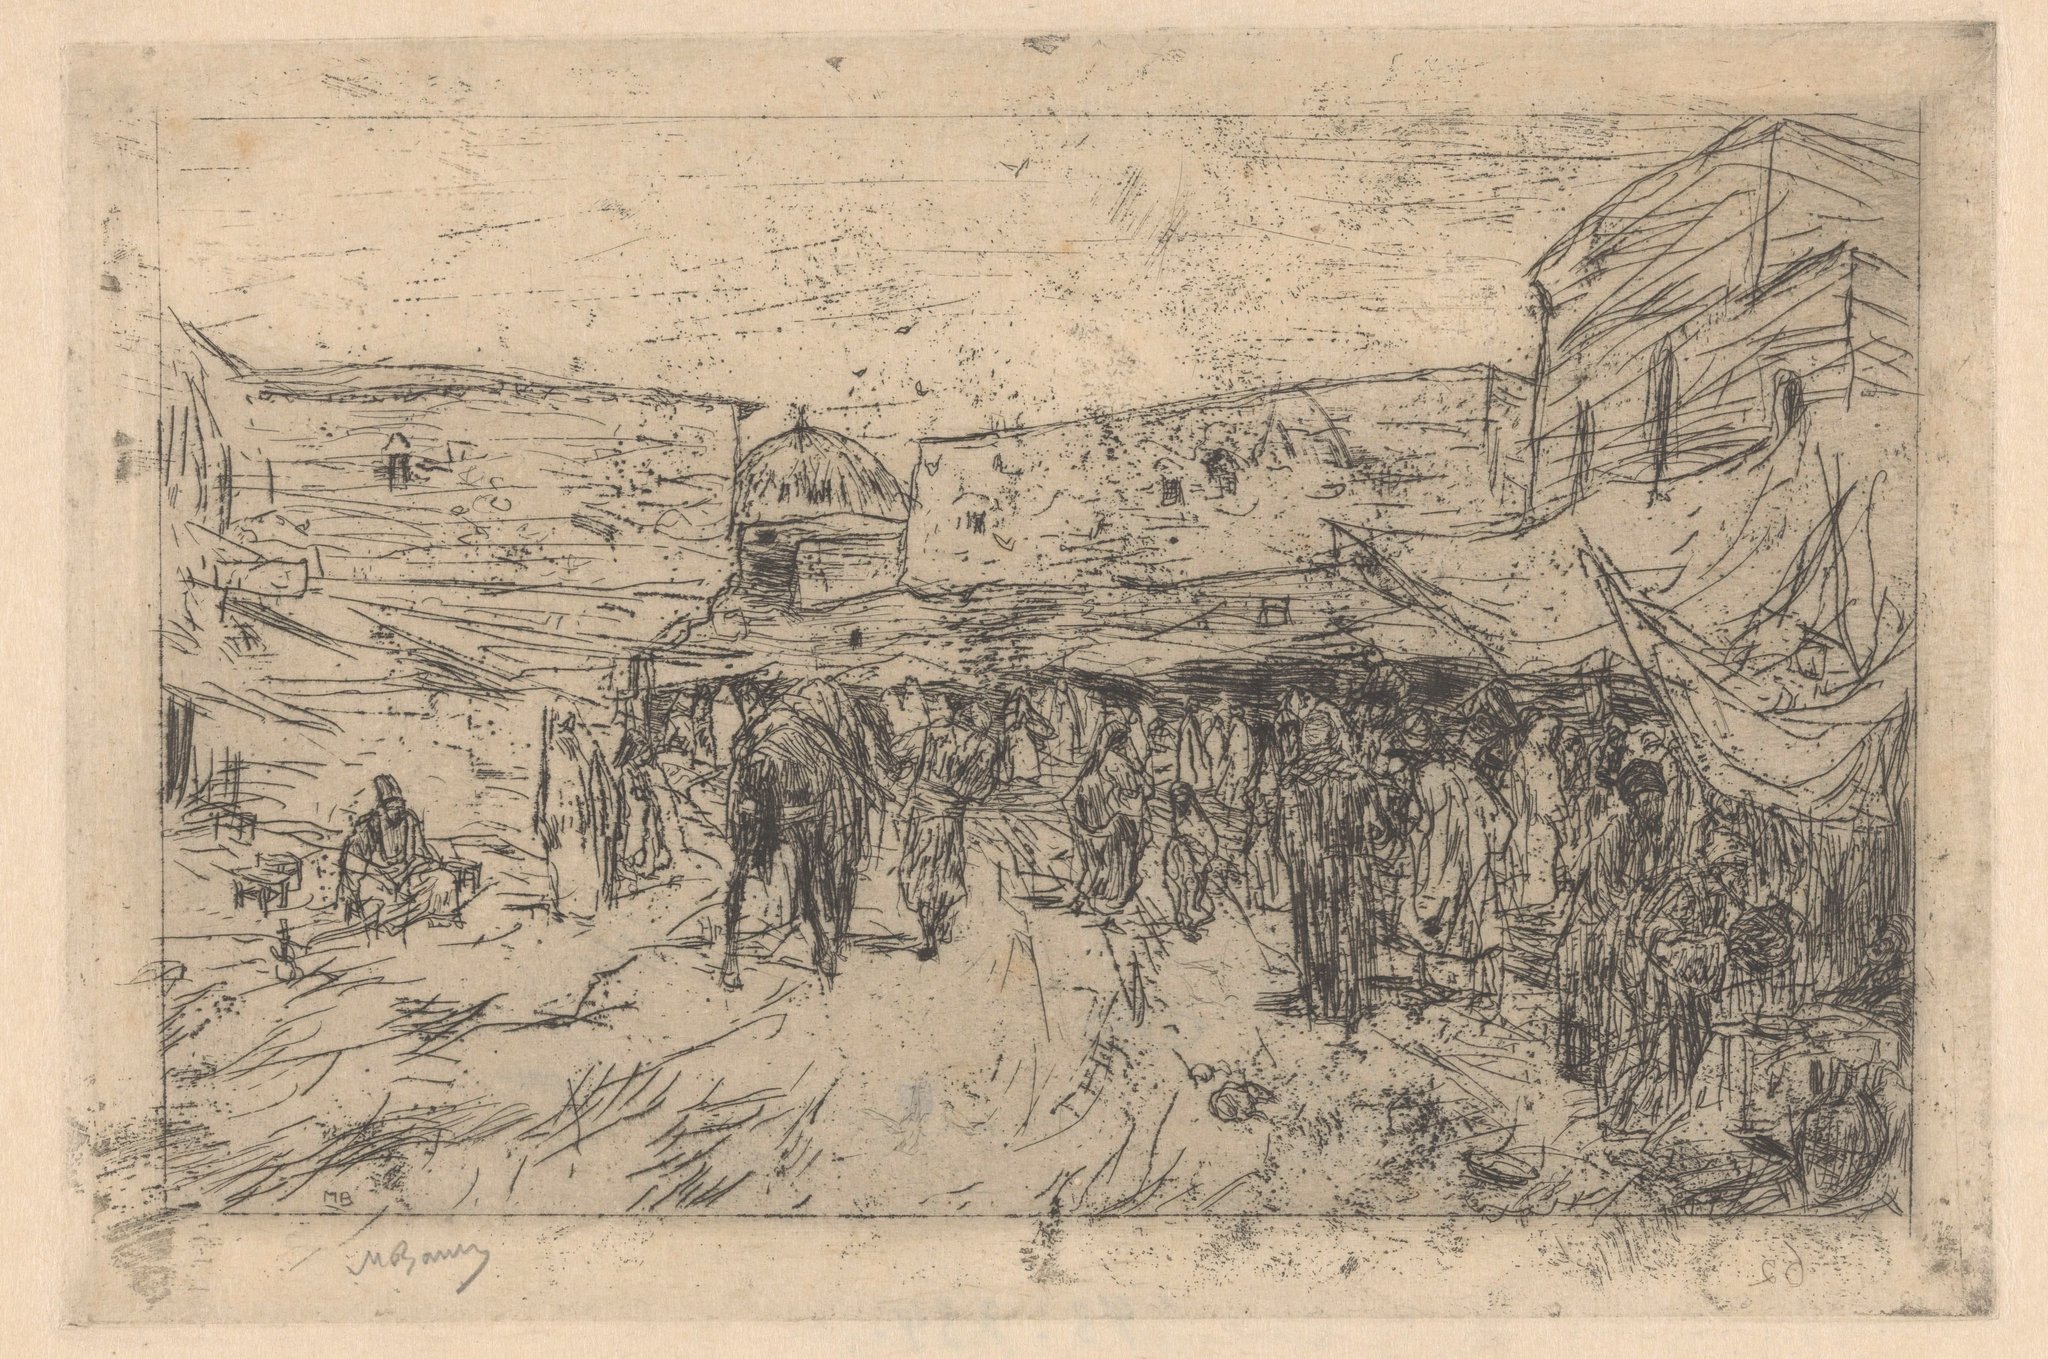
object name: print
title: Markt in Constantinopel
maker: marius bauer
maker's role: draughtsman, print maker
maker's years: 1867-1932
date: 1890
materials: paper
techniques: etching, intaglio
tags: market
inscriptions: collector's mark: Lugt 2760, collector's mark: Lugt 2228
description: Figuren op een markt, waaronder koopmannen zittend naast hun waren, een man lopend naast een lastdier, een man die een kruik bekijkt en verschillende gesluierde vrouwen. Onderaan is het nummer 62 in spiegelbeeld gedrukt.